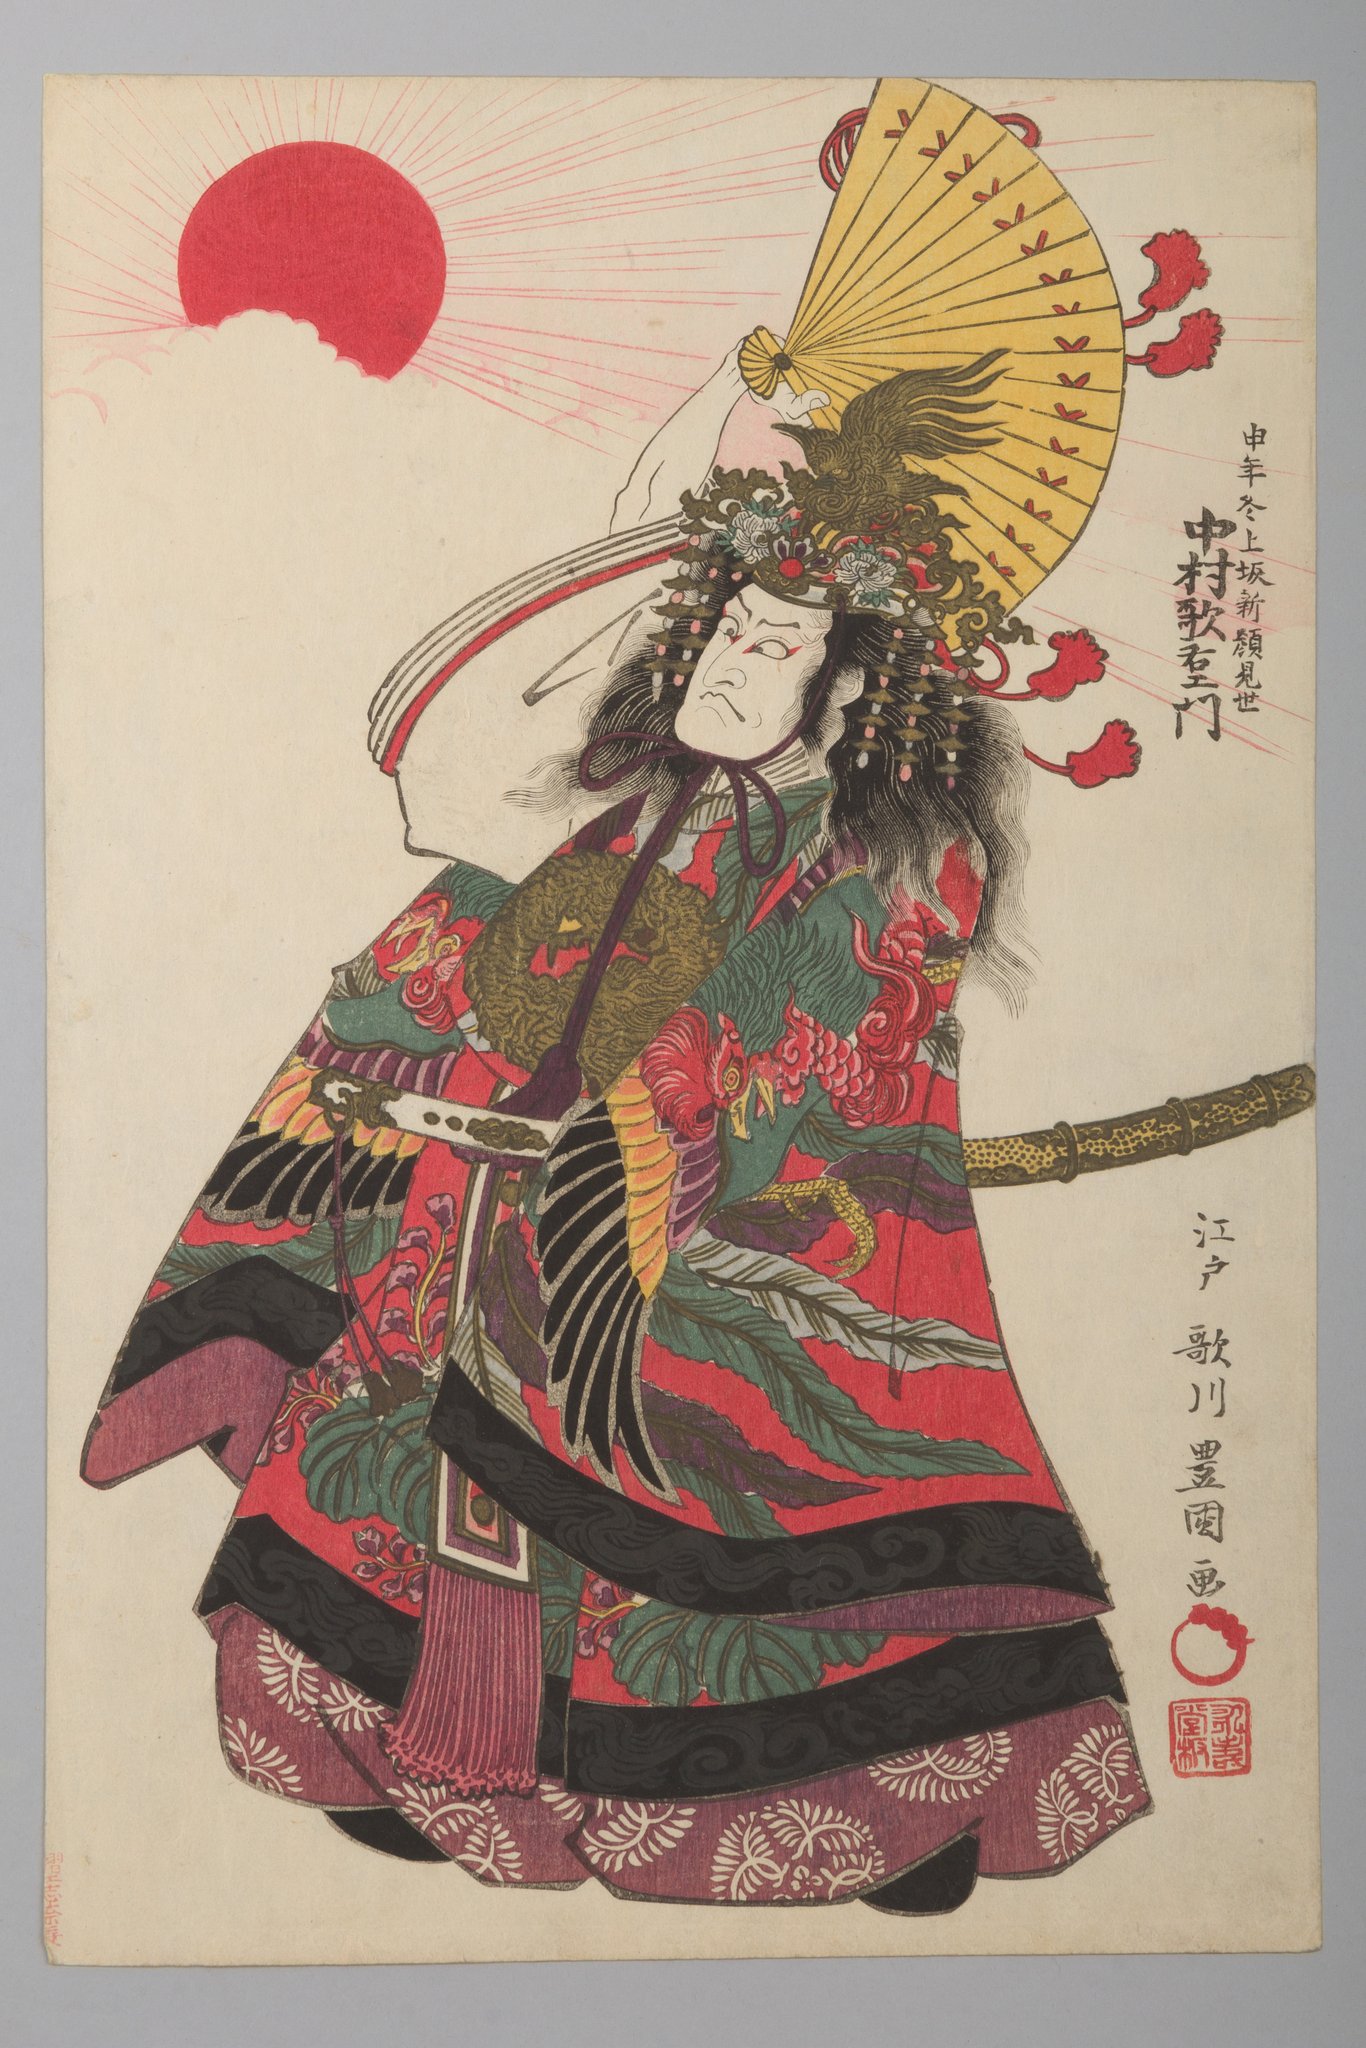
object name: woodblock print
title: Nakamura Utaemon III as Taira no Kiyomori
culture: japanese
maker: utagawa toyokuni i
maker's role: artist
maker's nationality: japanese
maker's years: 1769-1825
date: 1812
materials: lacquer, pigment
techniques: woodblock print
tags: fans,swords,men,sun,actors